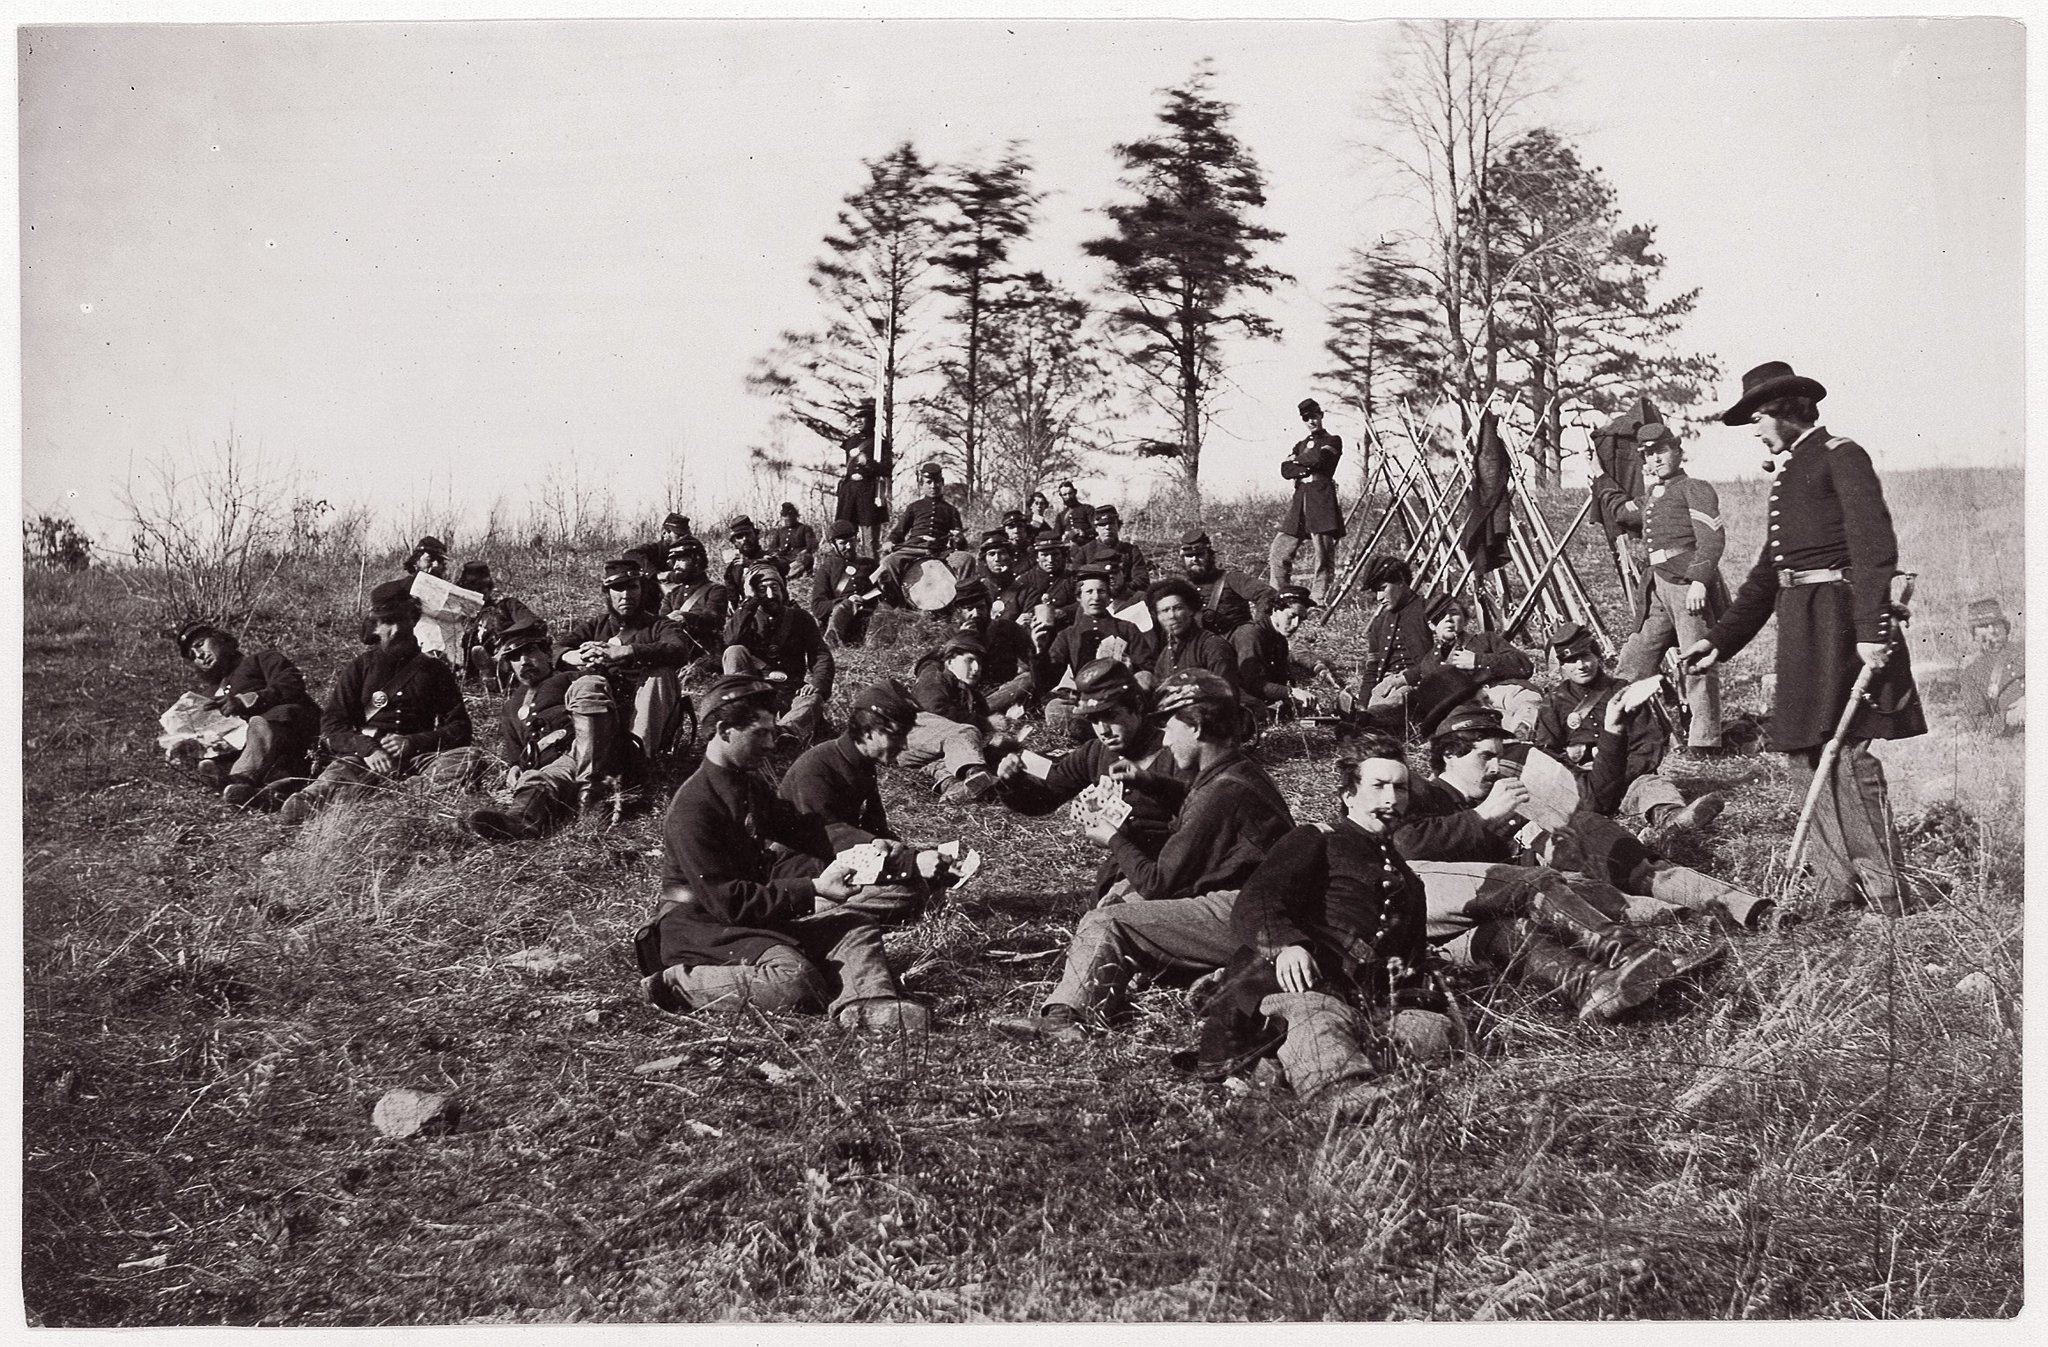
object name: photograph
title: Co. B, 170th New York Volunteers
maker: Anonymous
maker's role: artist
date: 1861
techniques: albumen silver print, glass negative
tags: army,soldiers,american civil war